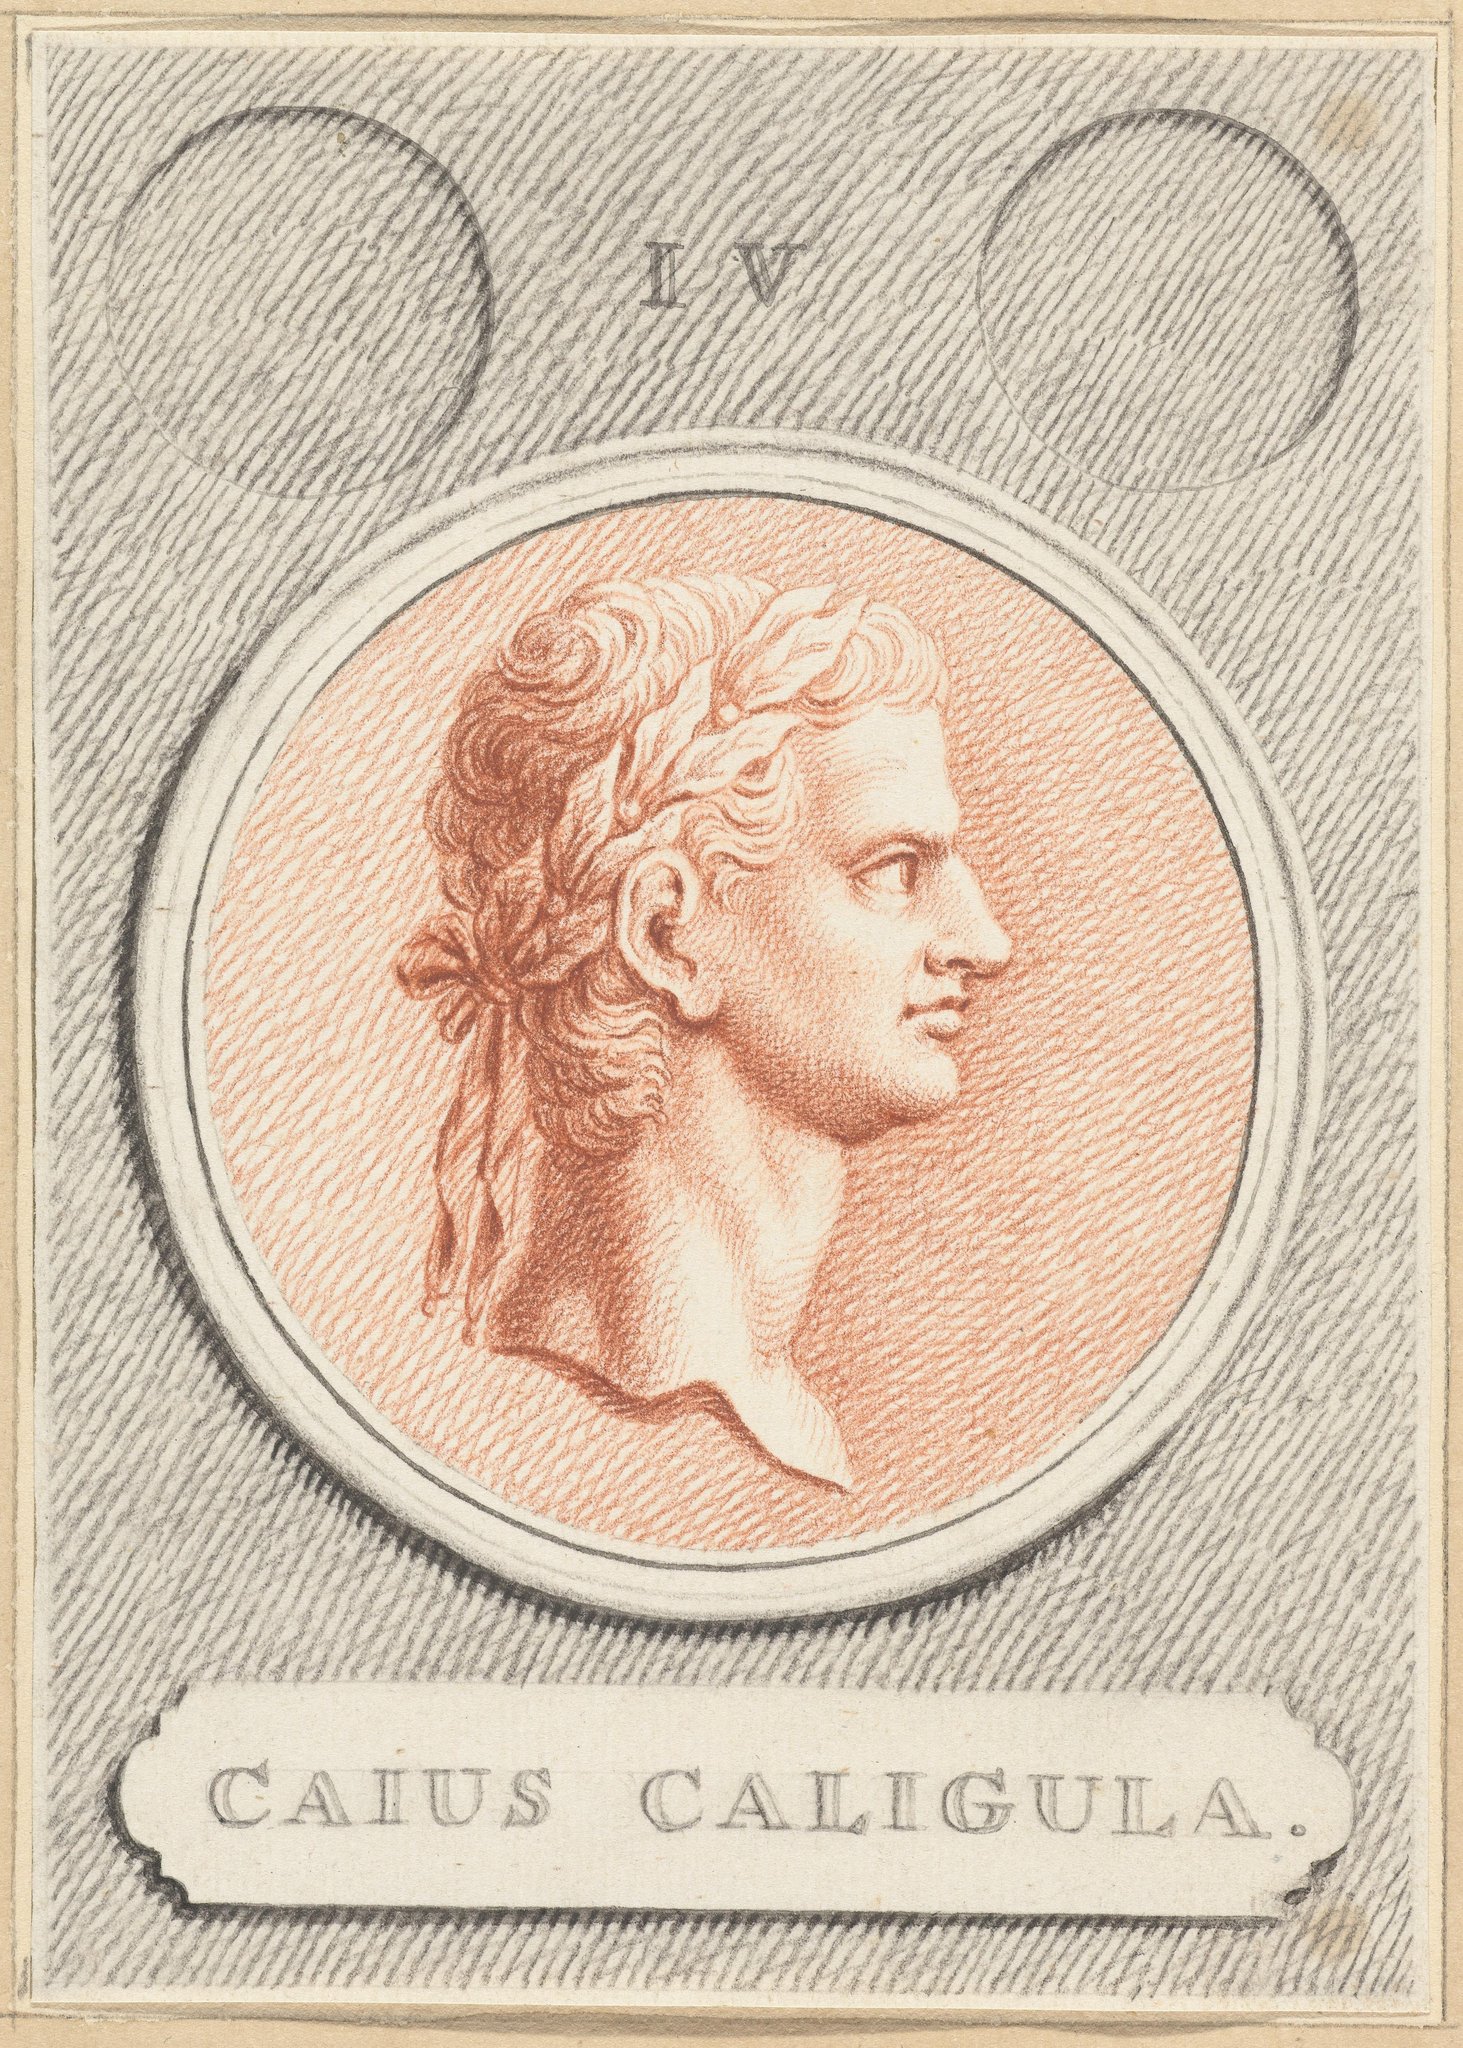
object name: drawing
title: Portretmedaillon van Caligula, Romeins keizer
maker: jan caspar philips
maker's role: draughtsman, print maker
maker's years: 1700-1775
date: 1736-1775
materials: chalk, ink, paper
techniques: brush, pen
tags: germany, rome, male persons from classical history (caligula) - portrait of person from classical history, historical persons